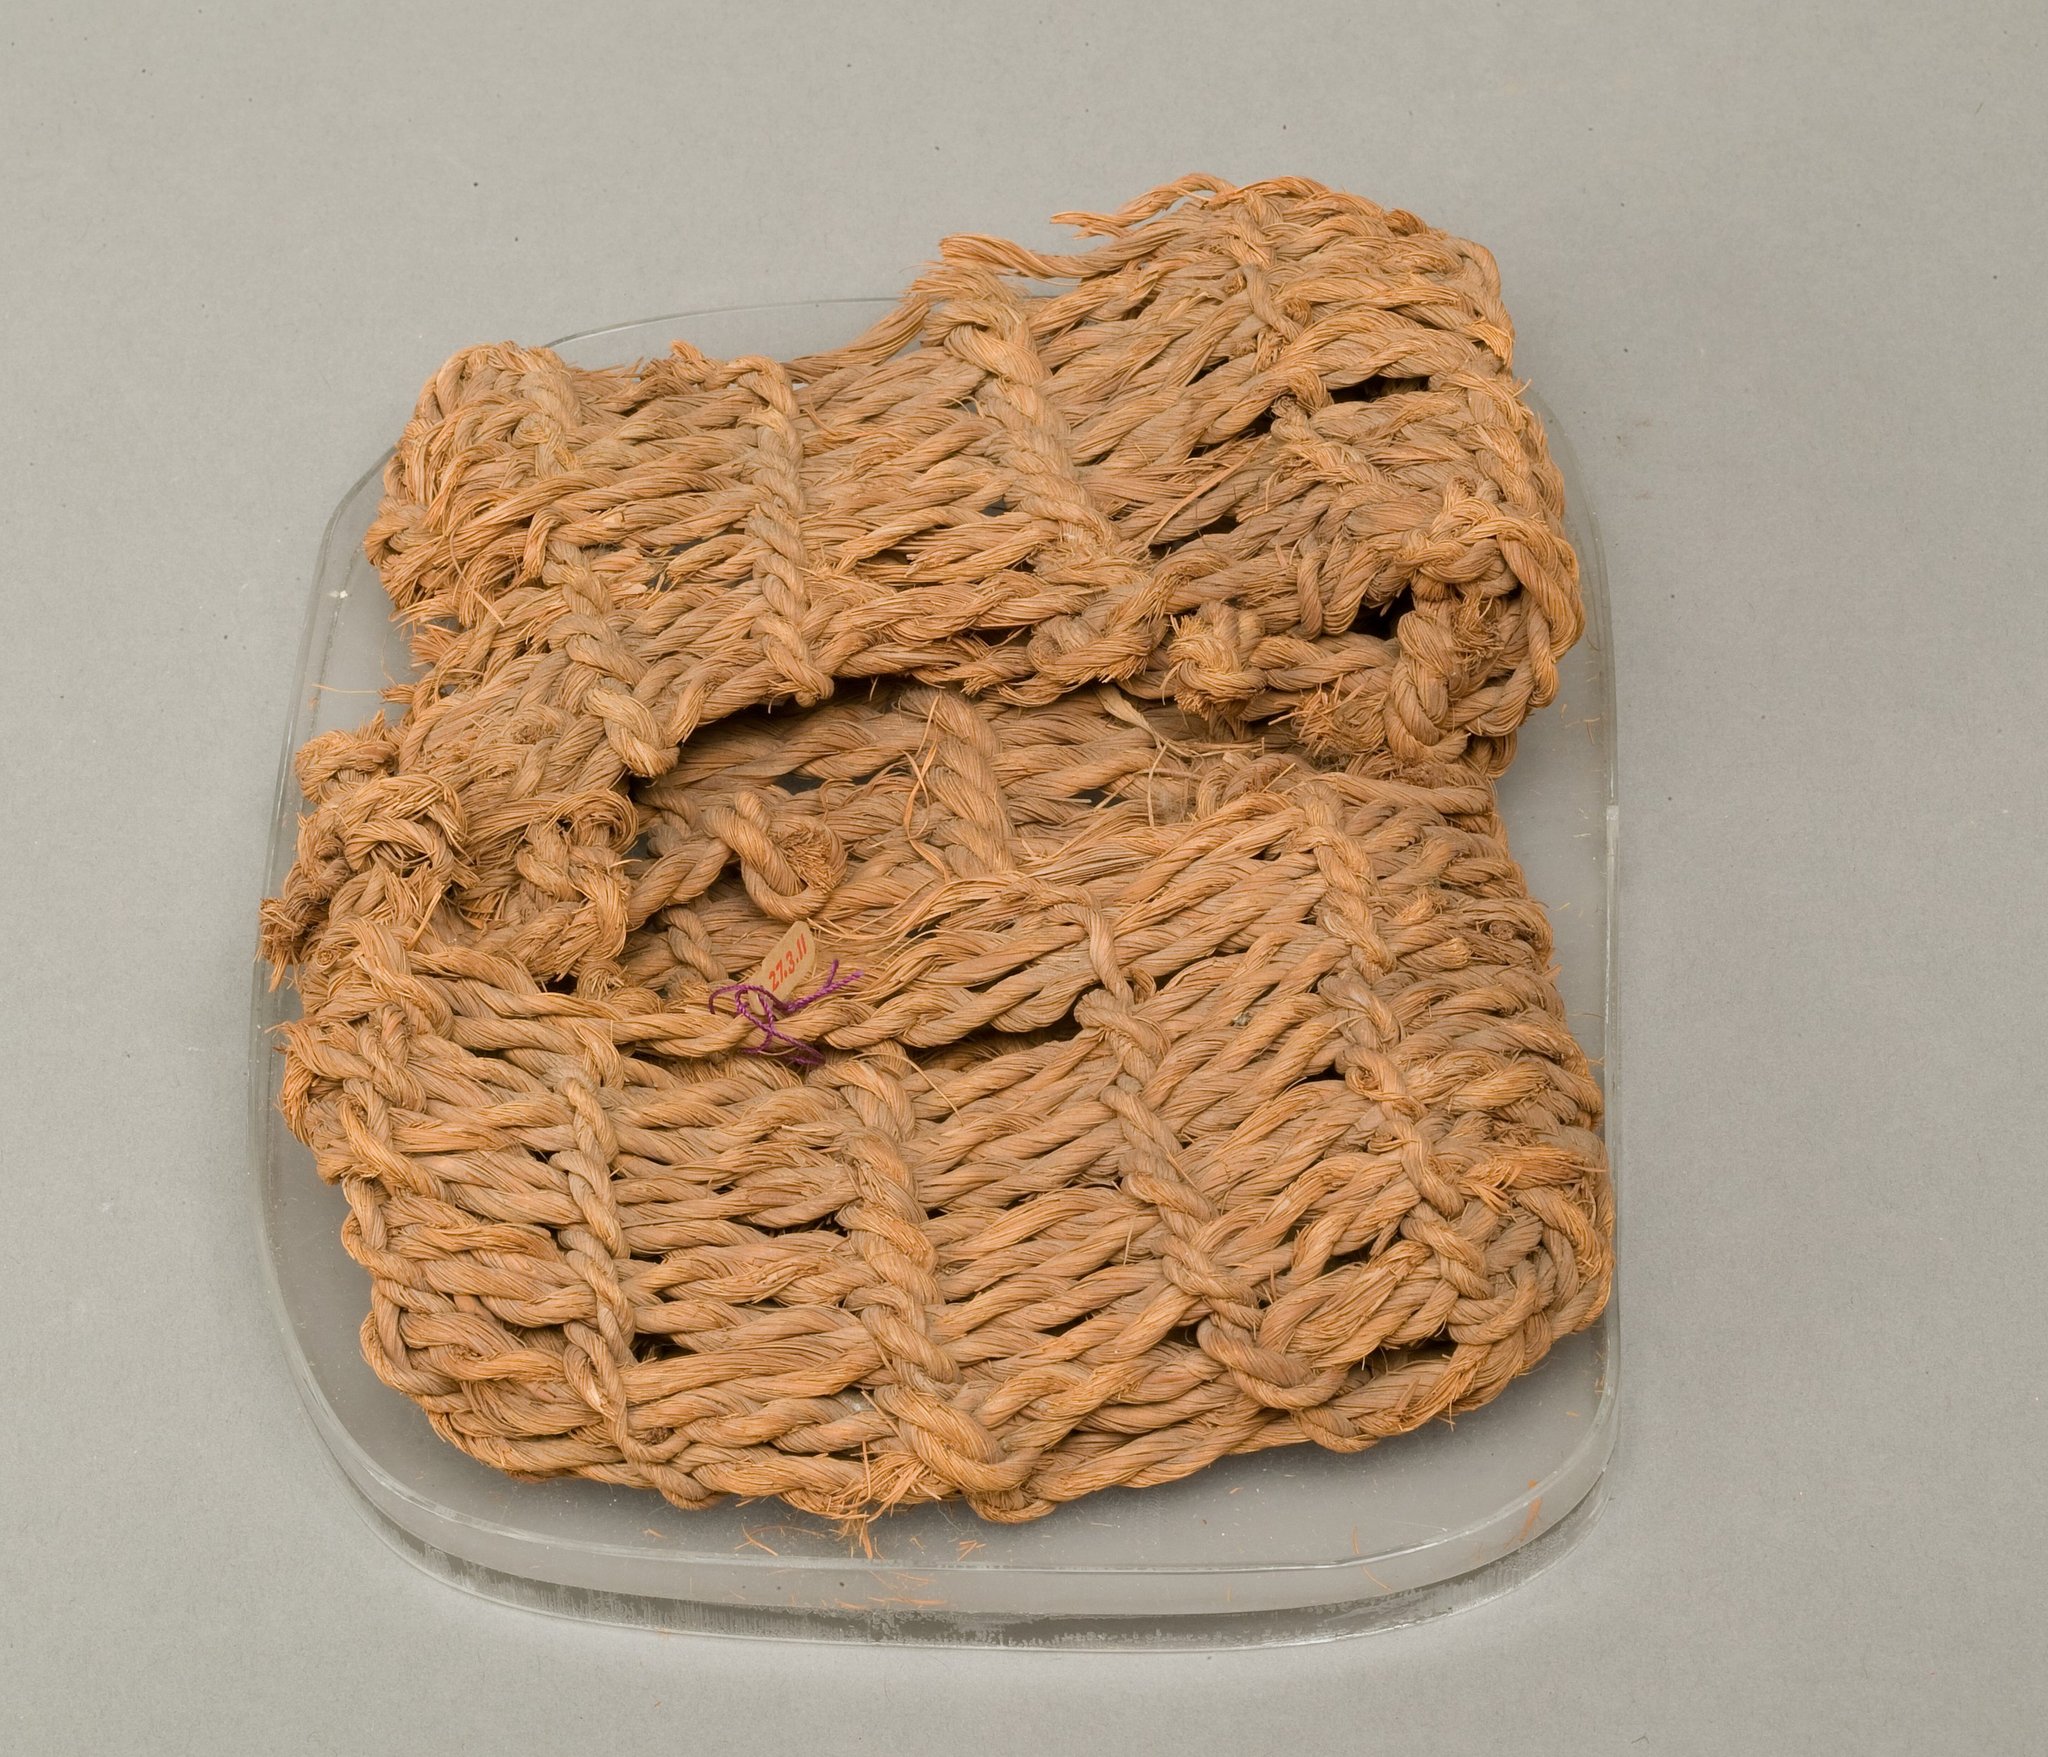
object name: model, saddle bag, donkey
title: Model Saddle Bag for a Donkey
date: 2051-2000 BCE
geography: egypt